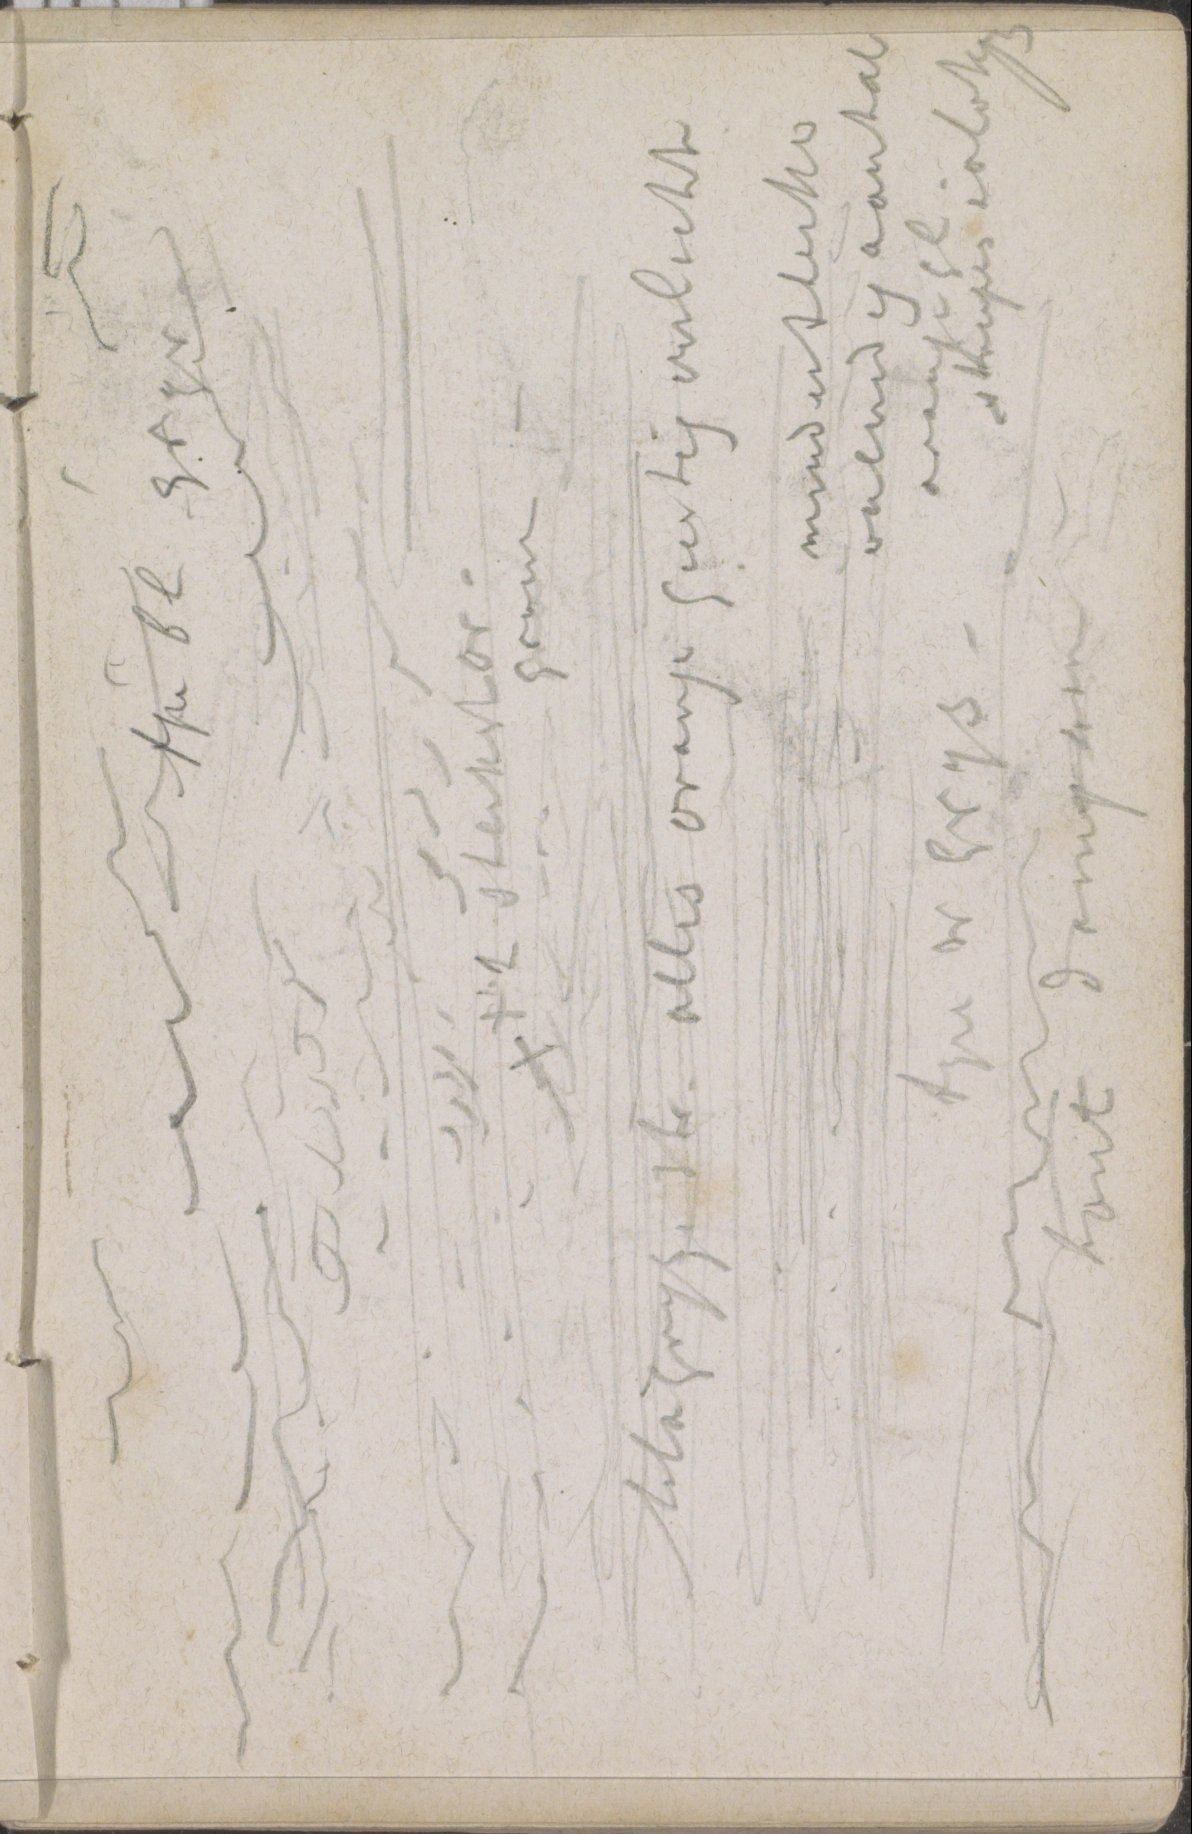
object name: sketchbook leaf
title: Landschap met een wolkenlucht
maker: johannes tavenraat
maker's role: draughtsman, painter, print maker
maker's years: 1809-1881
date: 1862-1864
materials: paper, pencil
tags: landscapes, clouds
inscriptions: kleurnotitie, handgeschreven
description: Blad 12 recto uit een schetsboek met 65 bladen.